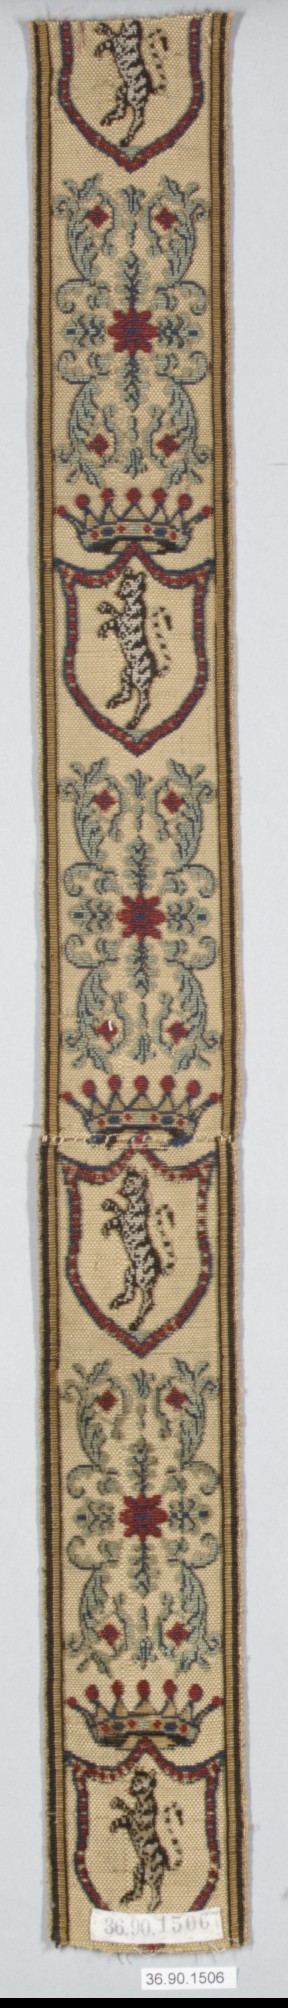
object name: galloon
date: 1701-1900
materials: silk